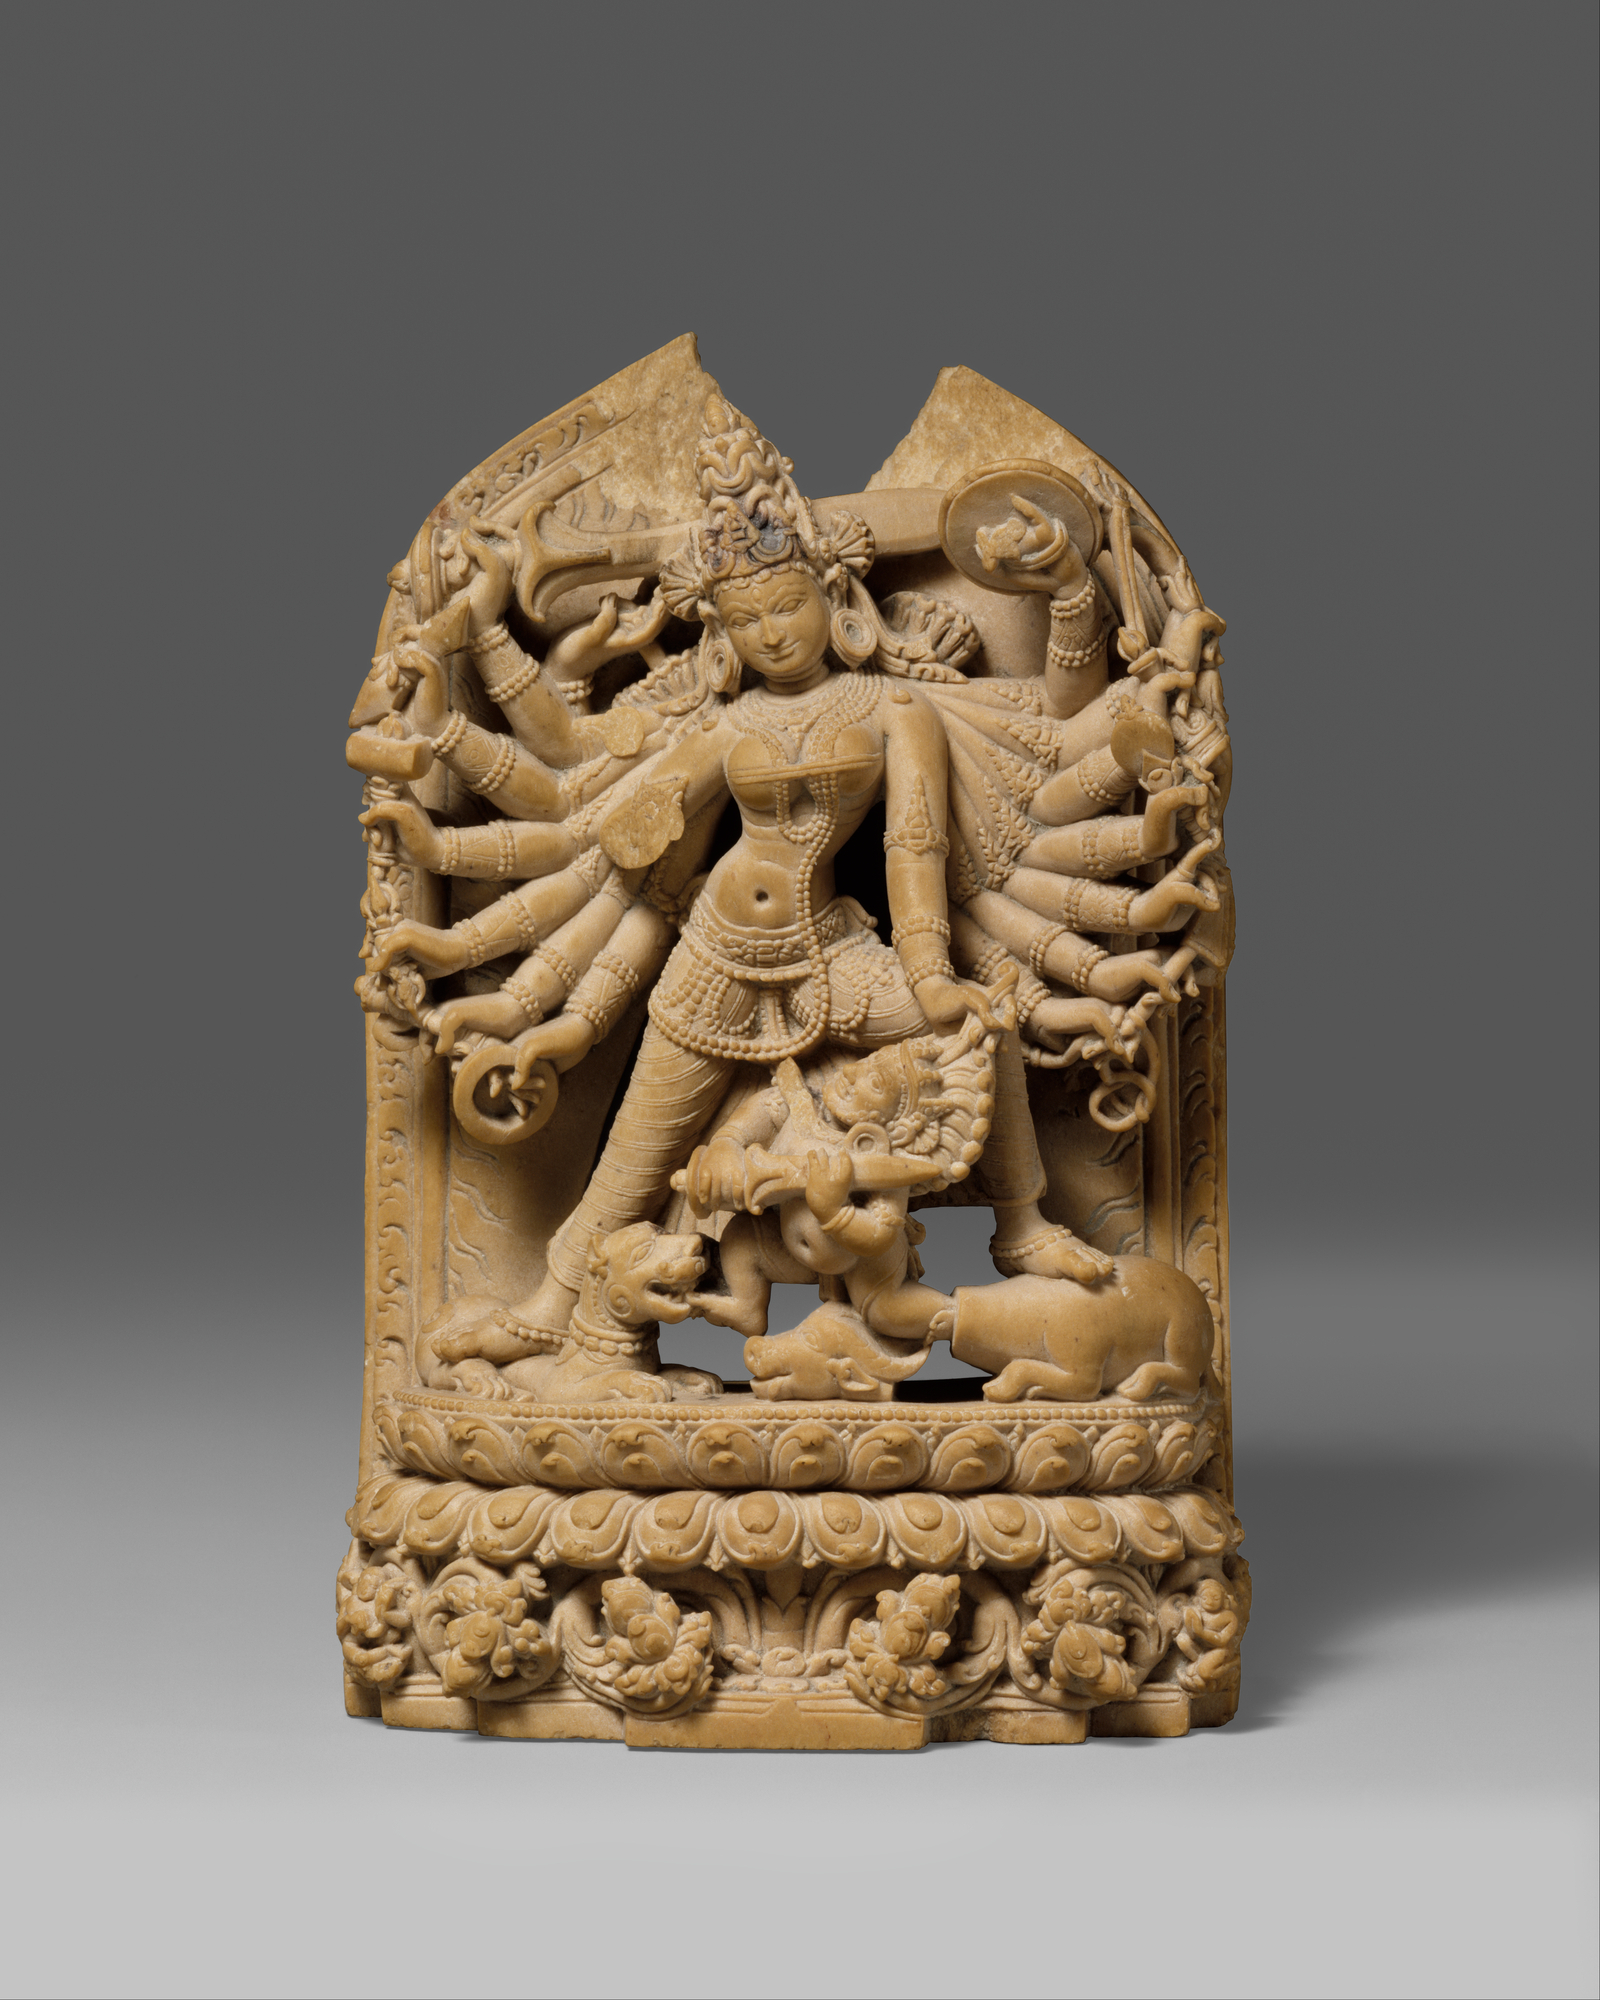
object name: figure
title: The Goddess Durga Slaying the Demon Buffalo Mahisha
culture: bangladeshi or indian or bengali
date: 1101-1200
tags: swords,demons,durga,hinduism